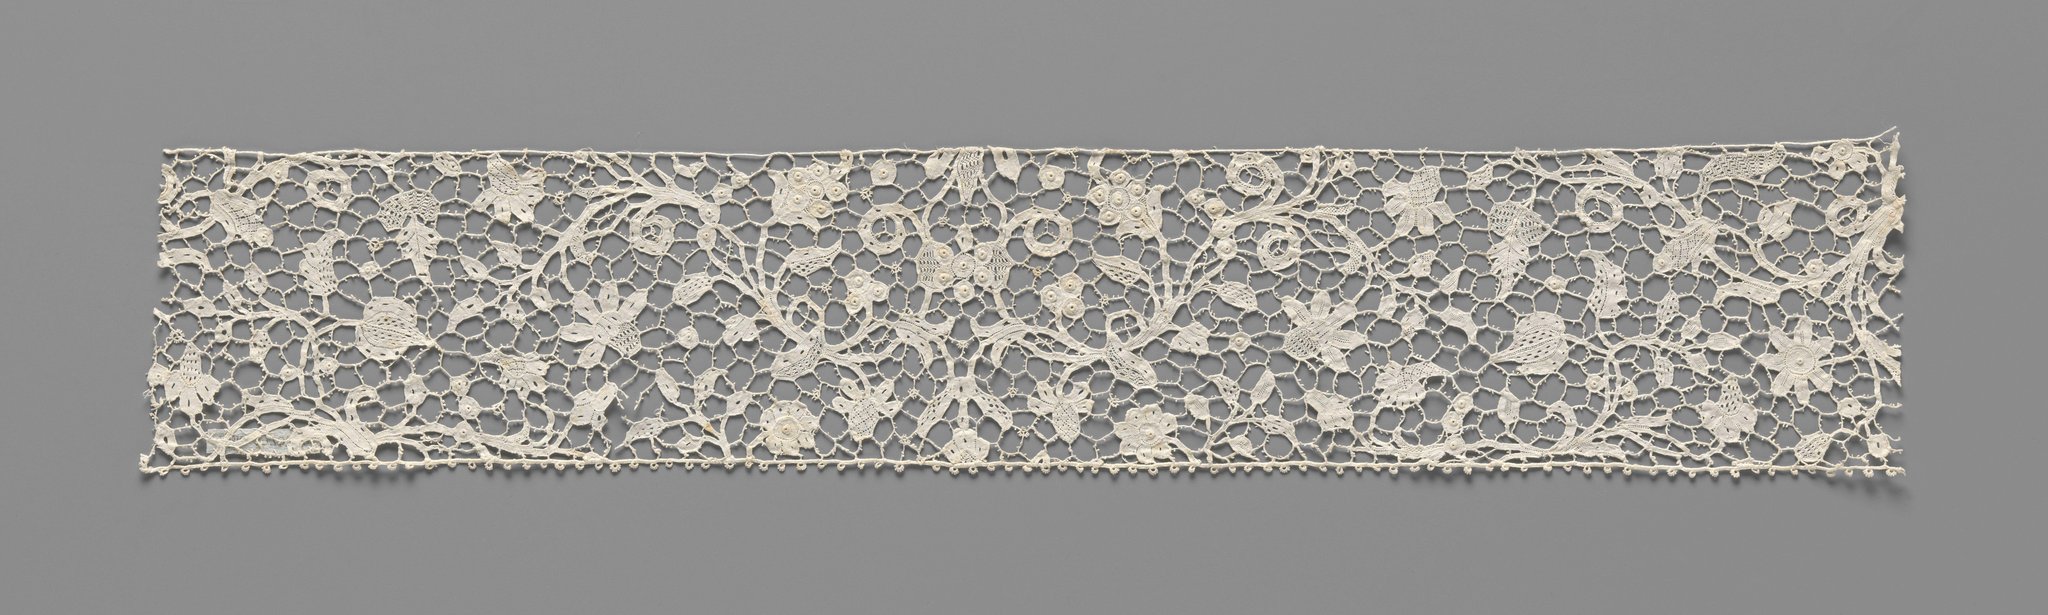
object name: strip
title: Strook naaldkant met cirkelvormige bloemblaadjes en symmetrisch rankenpatroon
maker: Anonymous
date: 1650-1699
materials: linen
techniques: flat venetian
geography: italy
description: Strook naturelkleurig naaldkant: Venise plat. Symmetrisch patroon van krullende ranken met veelsoortige bloemen en blaadjes. Verschillende bloemen met cirkelvormige bloemblaadjes vallen op. Onregelmatige open spijlengrond met picots. De bovenzijde is afgewerkt met een rechte rand. De onderzijde is afgewerkt met een rechte rand met raderpicots.